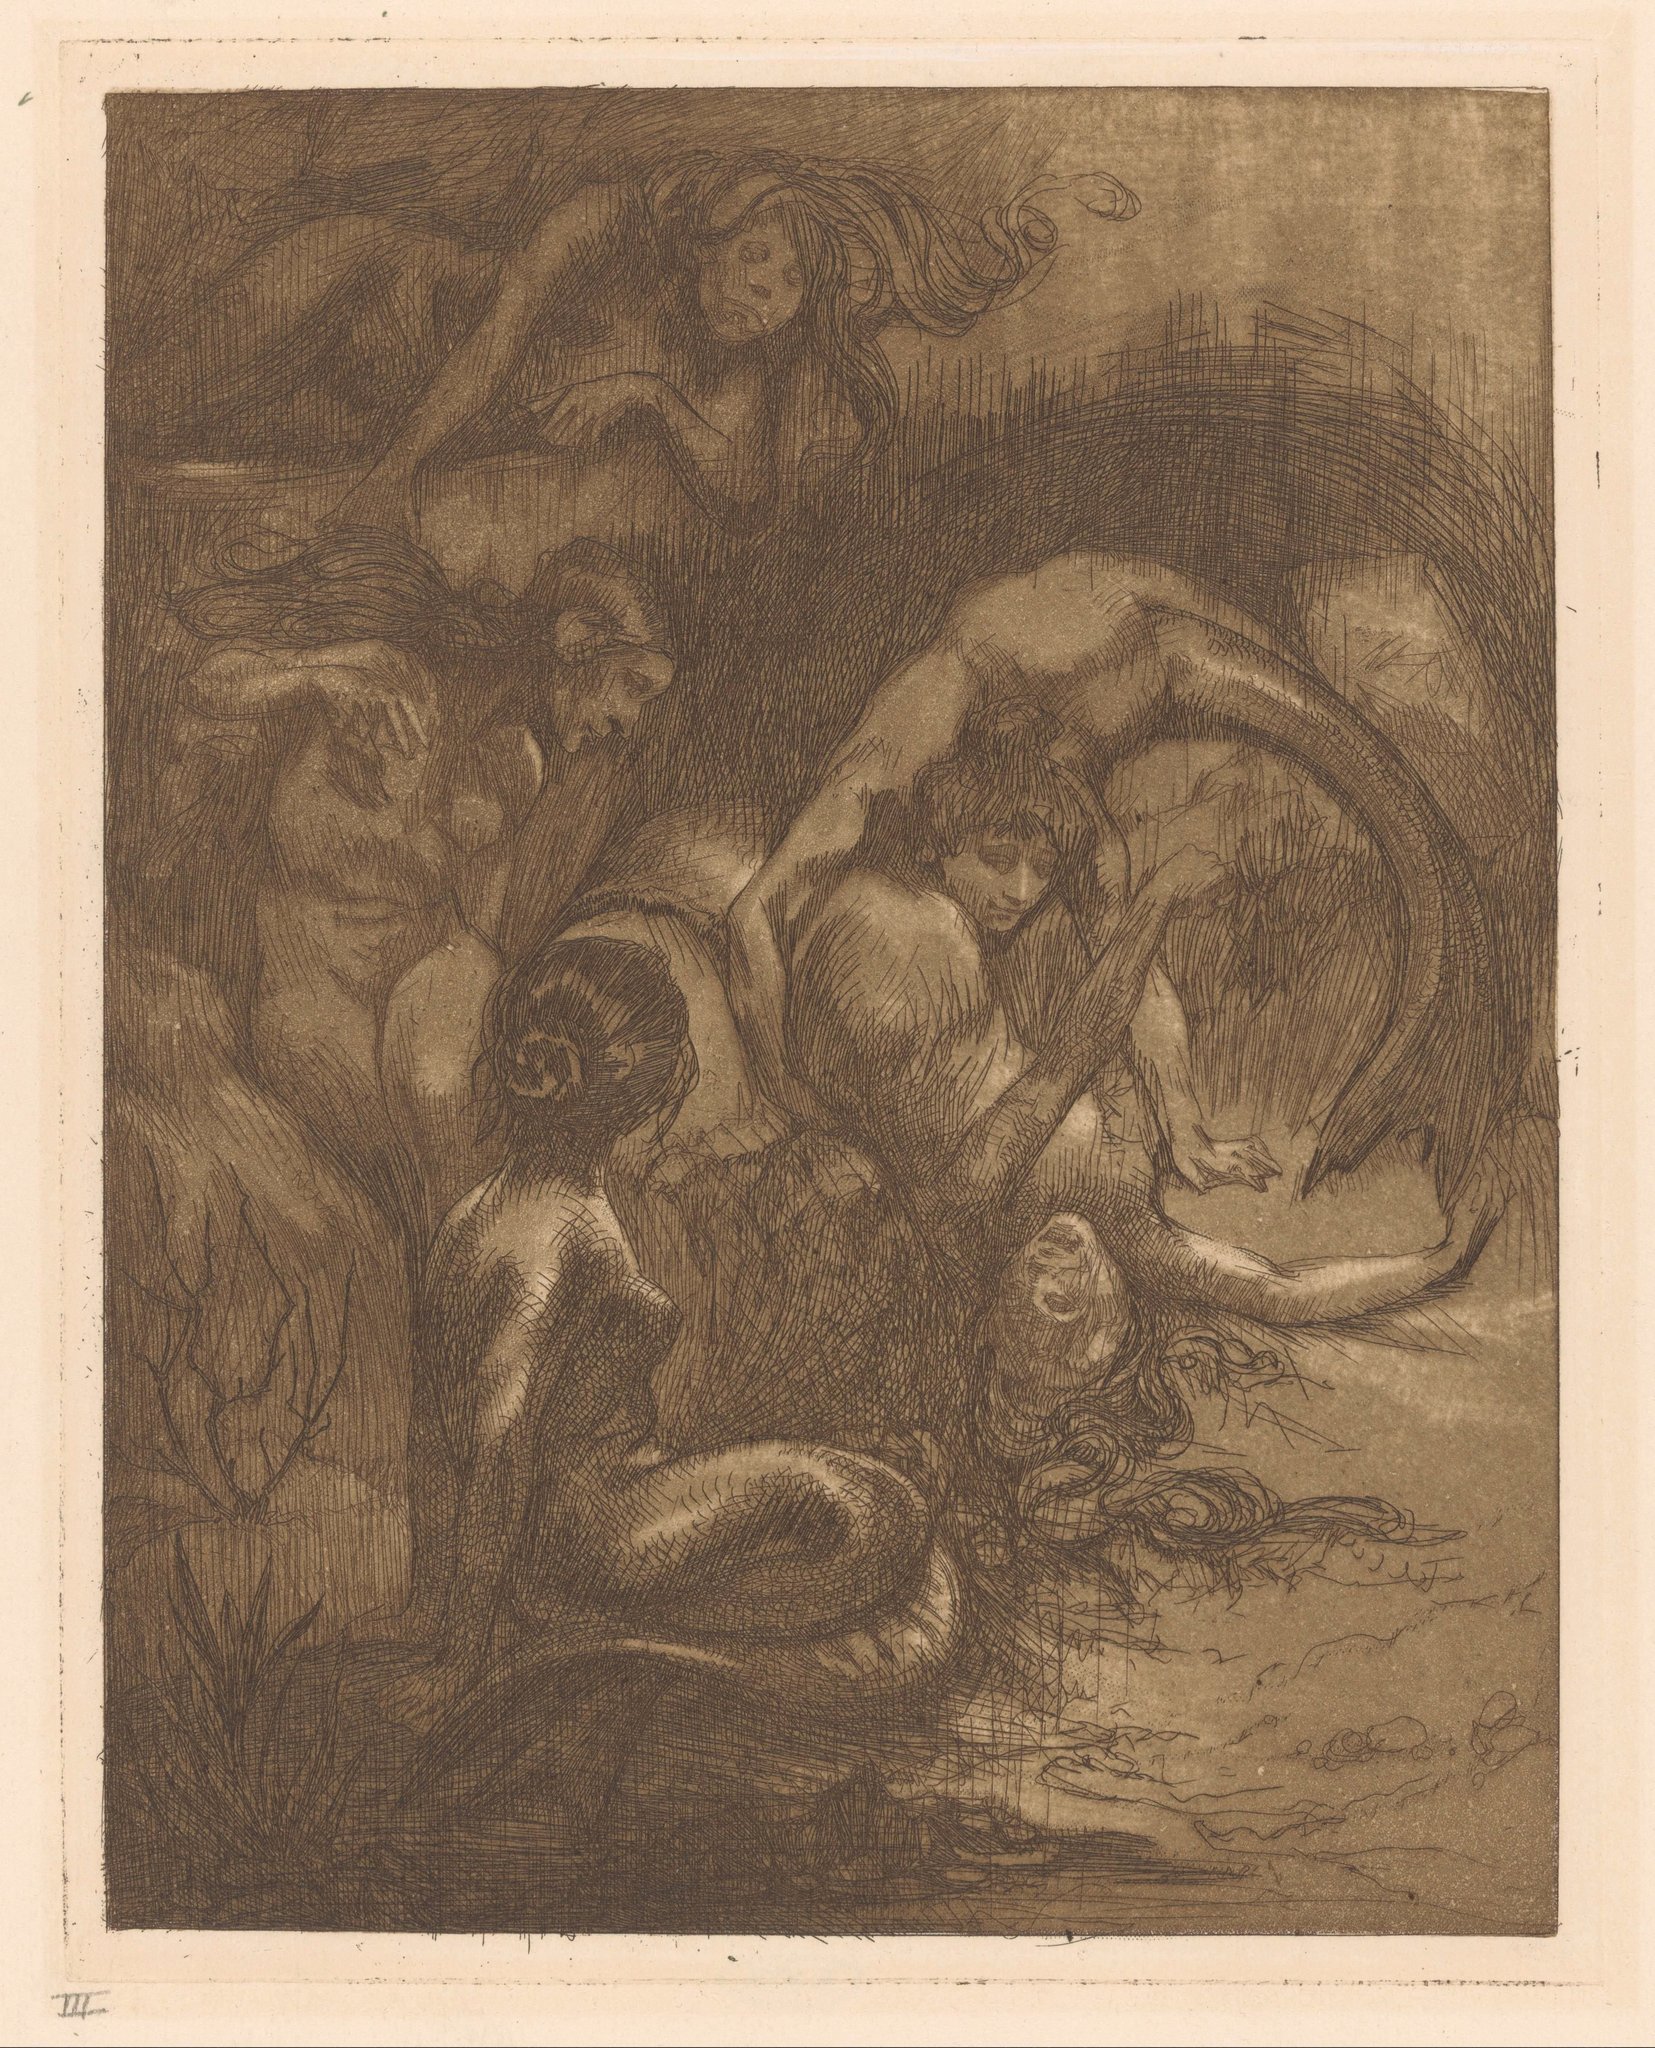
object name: print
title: Fantastische compositie met zeemeerminnen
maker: johannes josephus aarts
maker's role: draughtsman, print maker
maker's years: 1871-1934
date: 1881-1934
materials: paper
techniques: aquatint, etching, roulette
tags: merman - aa - mermaid, siren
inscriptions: collector's mark: Lugt 2166, collector's mark: Lugt 2228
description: Een groep van vijf zeemeerminnen bevindt zich onder water. Links op de voorgrond twee waterplanten.